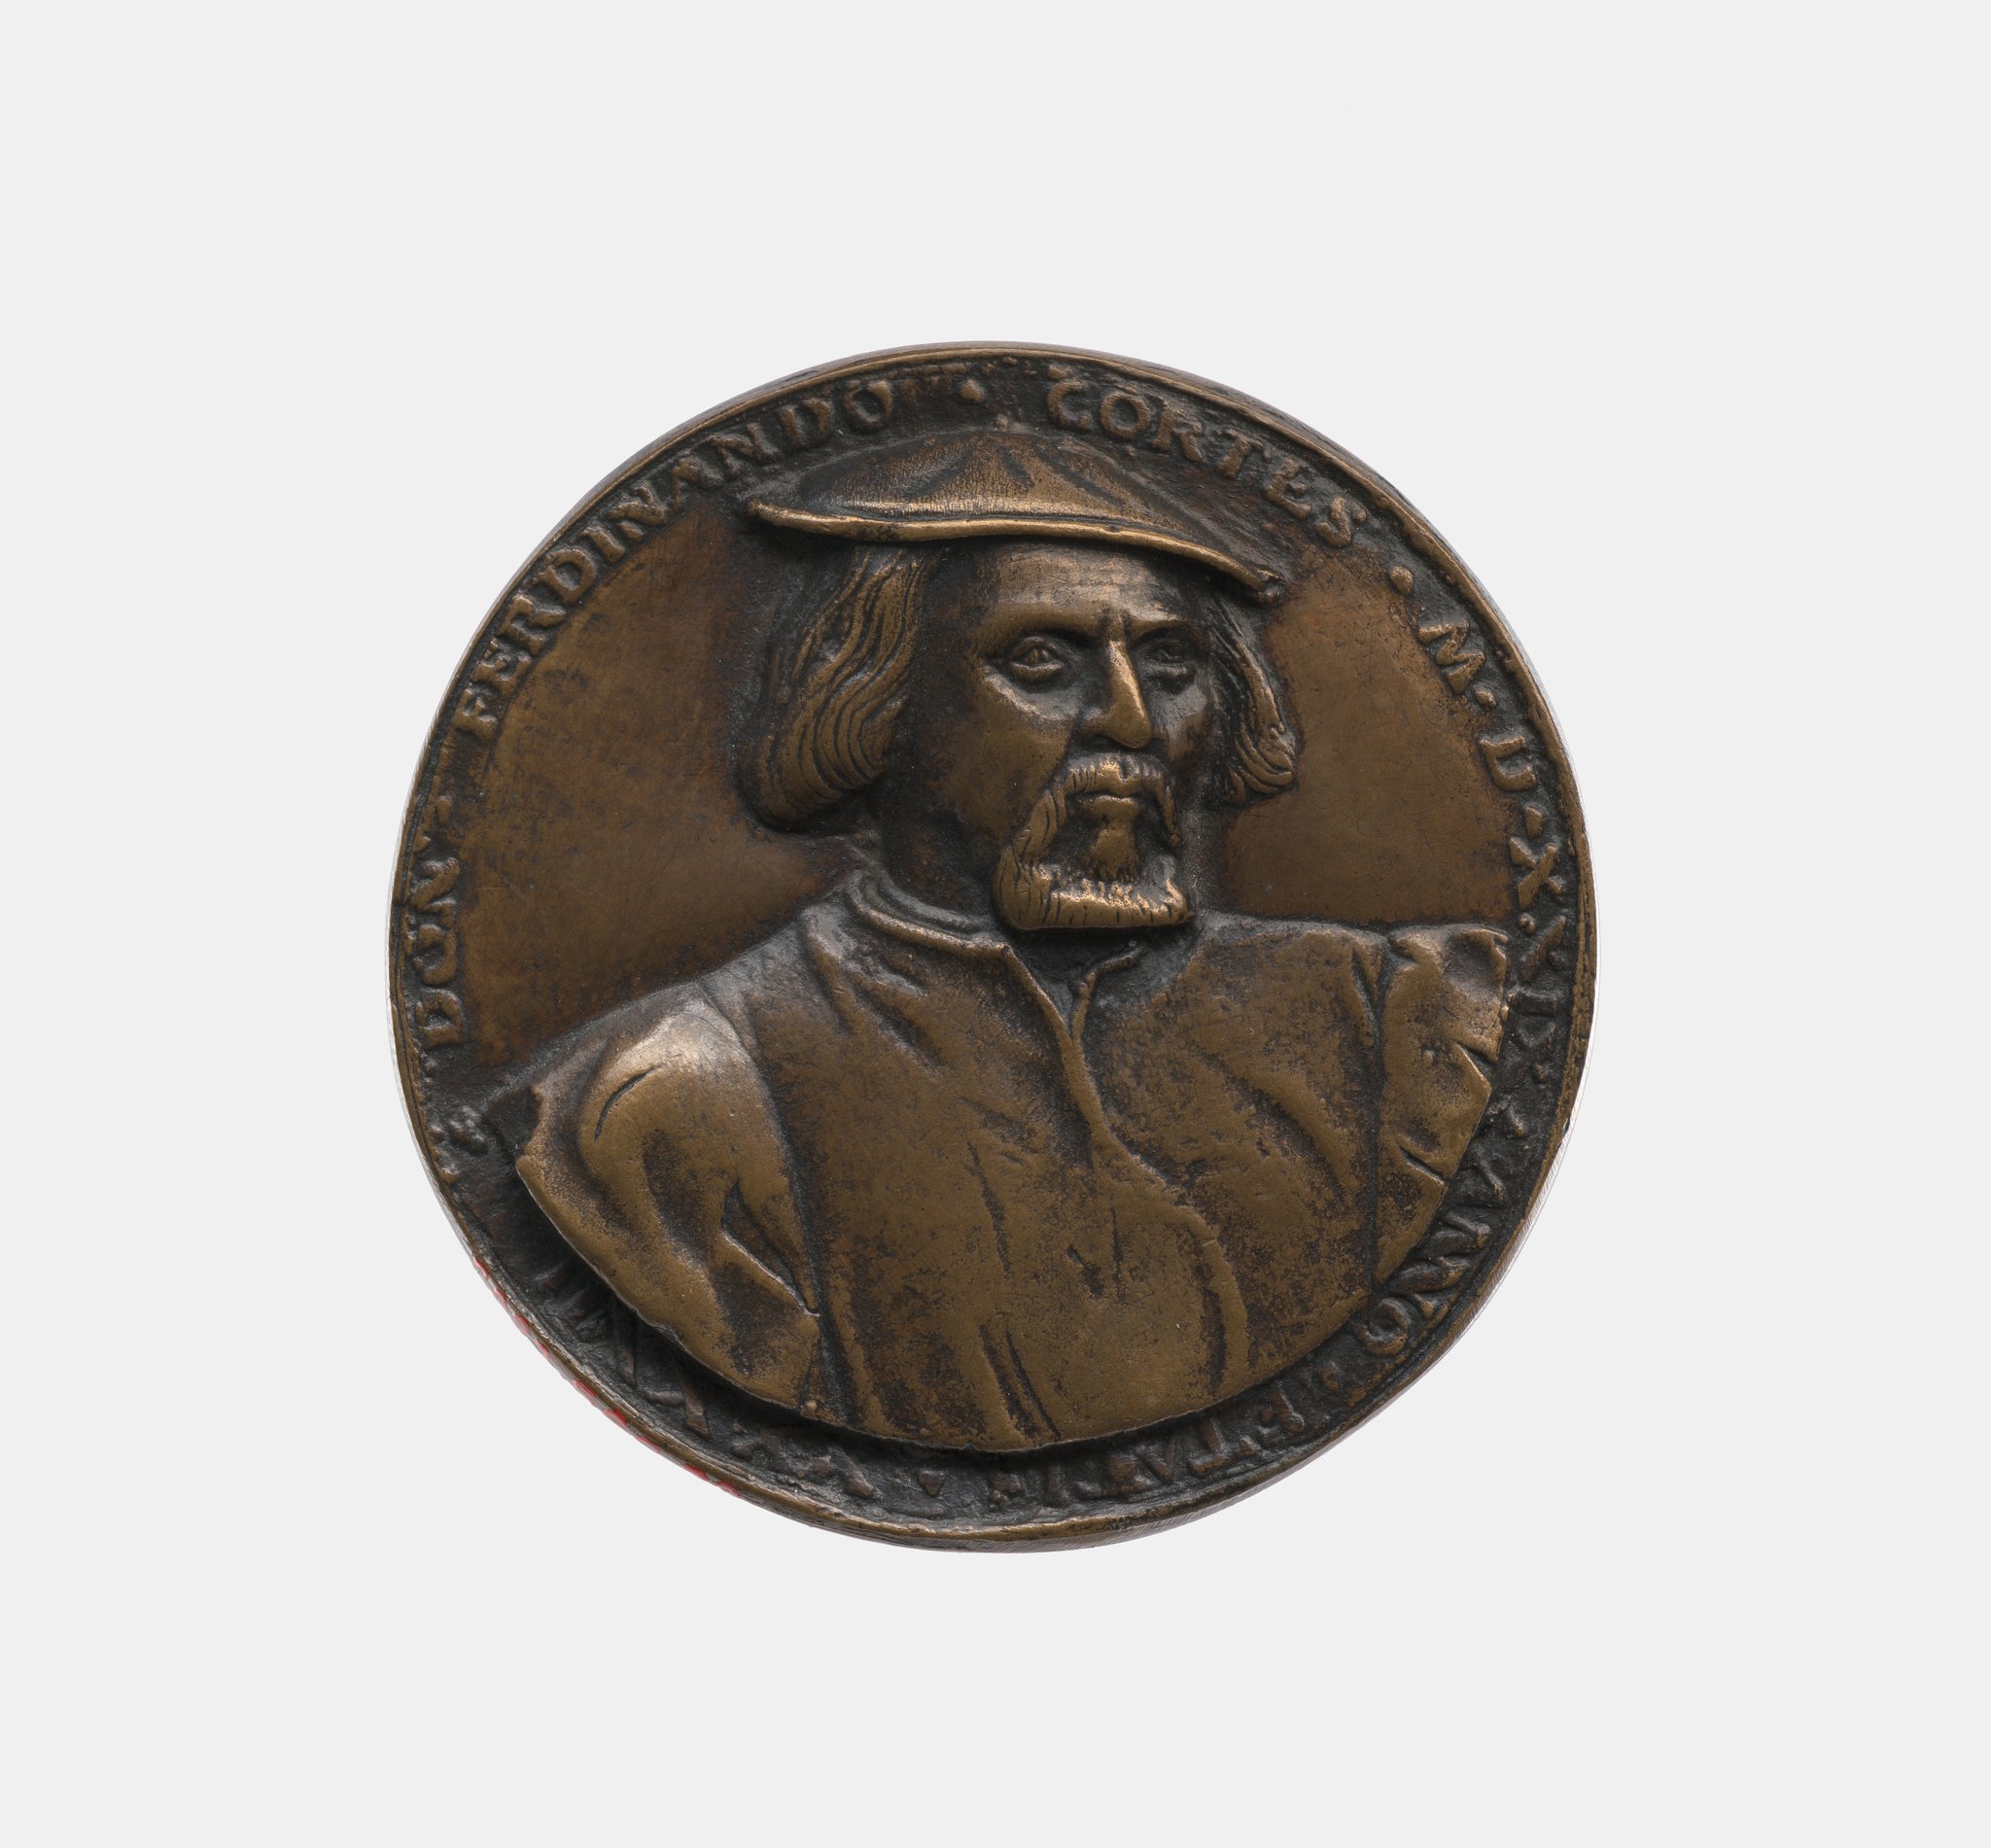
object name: medal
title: Hernan Cortez 1485-1547, Conquistador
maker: christoph weiditz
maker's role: artist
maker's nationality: german, strassburg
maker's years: 1500-1559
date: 1529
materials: bronze